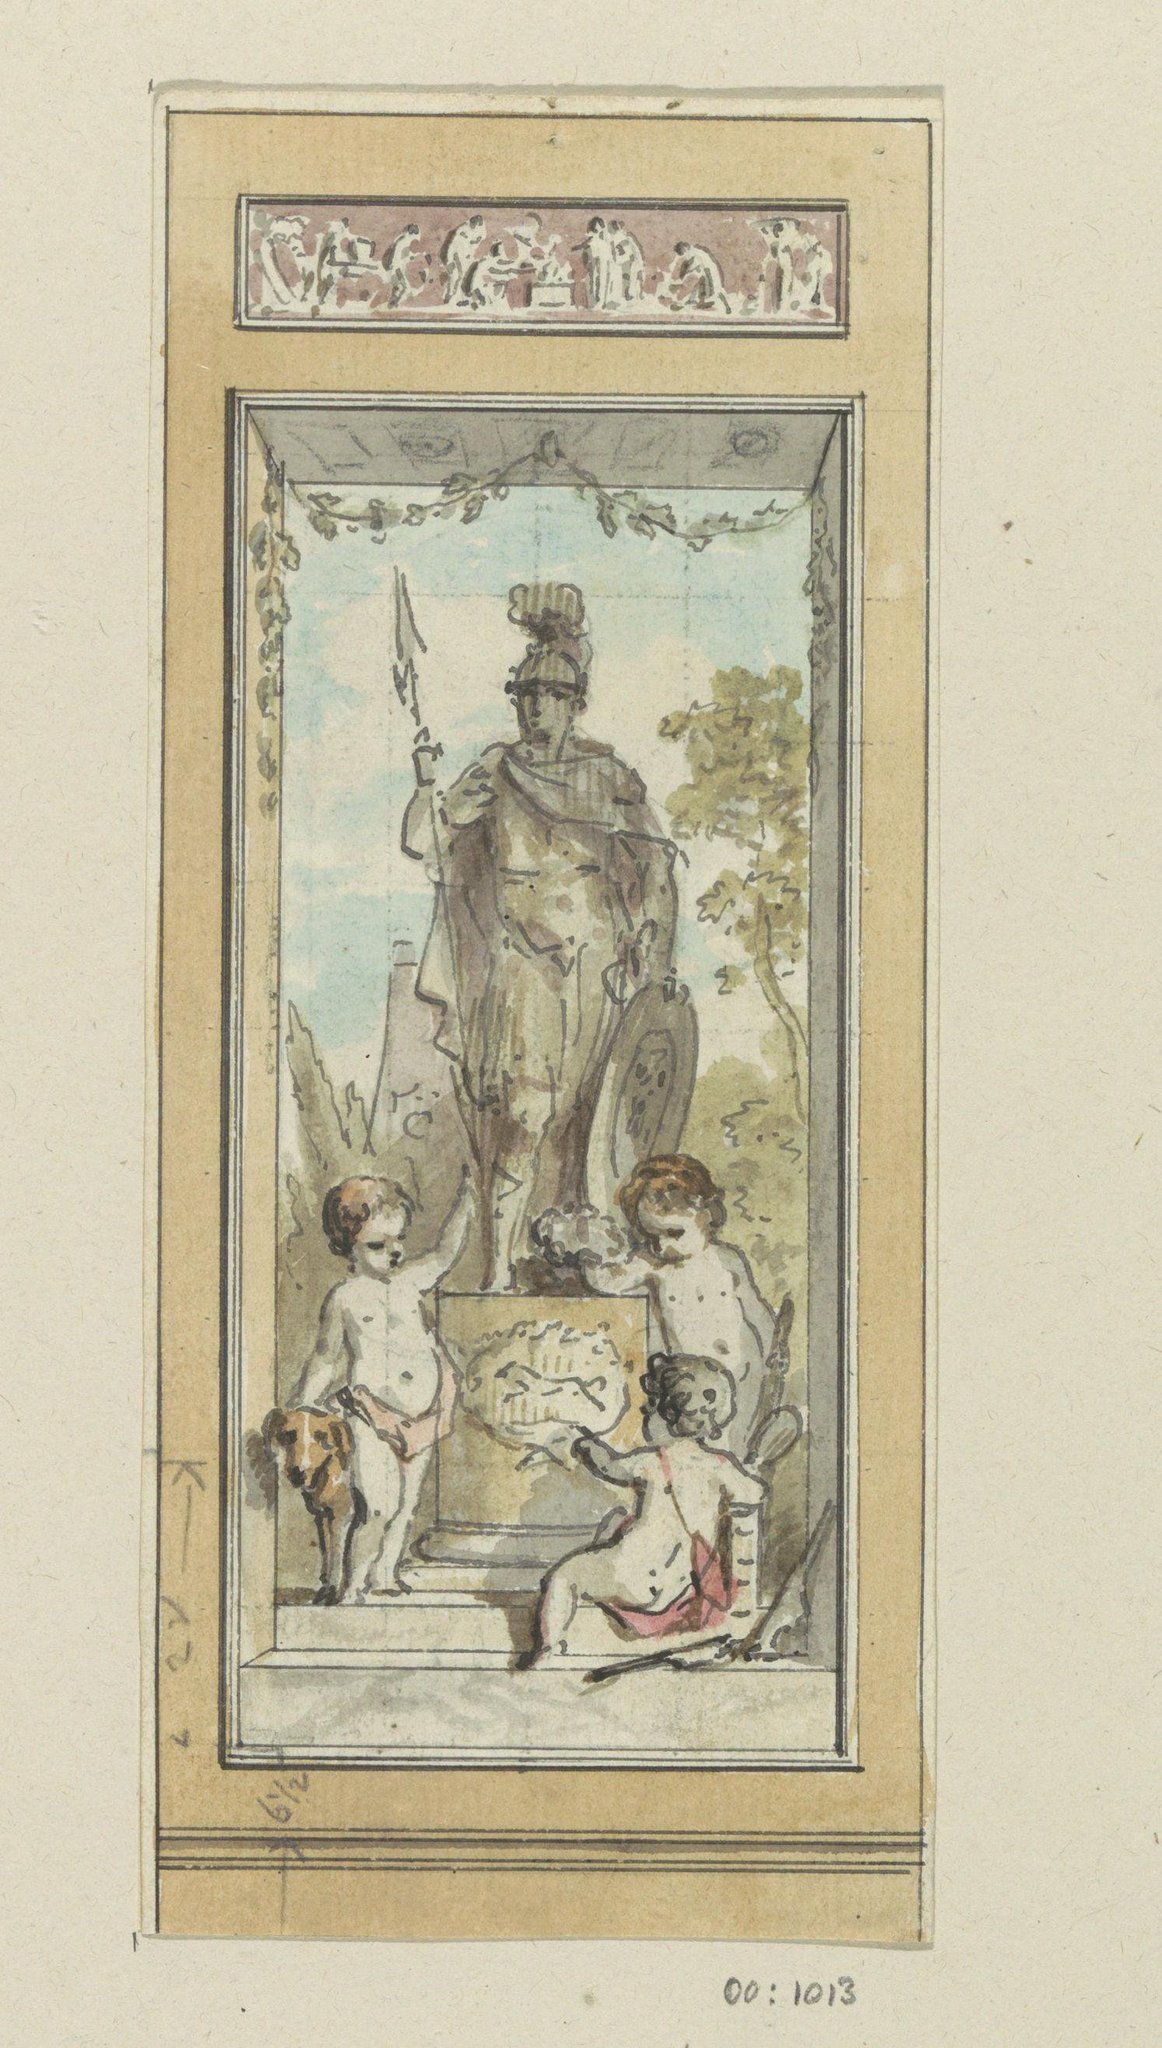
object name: album leaf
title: Ontwerptekening voor een kamerwand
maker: jurriaan andriessen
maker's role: draughtsman, painter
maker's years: 1742-1819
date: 1760-1819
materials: paint, paper, pencil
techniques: brush, pen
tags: (story of) minerva (pallas, athena), sculpture, wall-covering, cupids: 'amores', 'amoretti', 'putti'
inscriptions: inscription: ‘voor de hr Hk. A. Muller/ op de zaal/ 176’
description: Met een sculptuur van Minerva met aan de voet drie putti. Met in de linkermarge een paar afmetingen. Tekening maakt deel uit van een album.